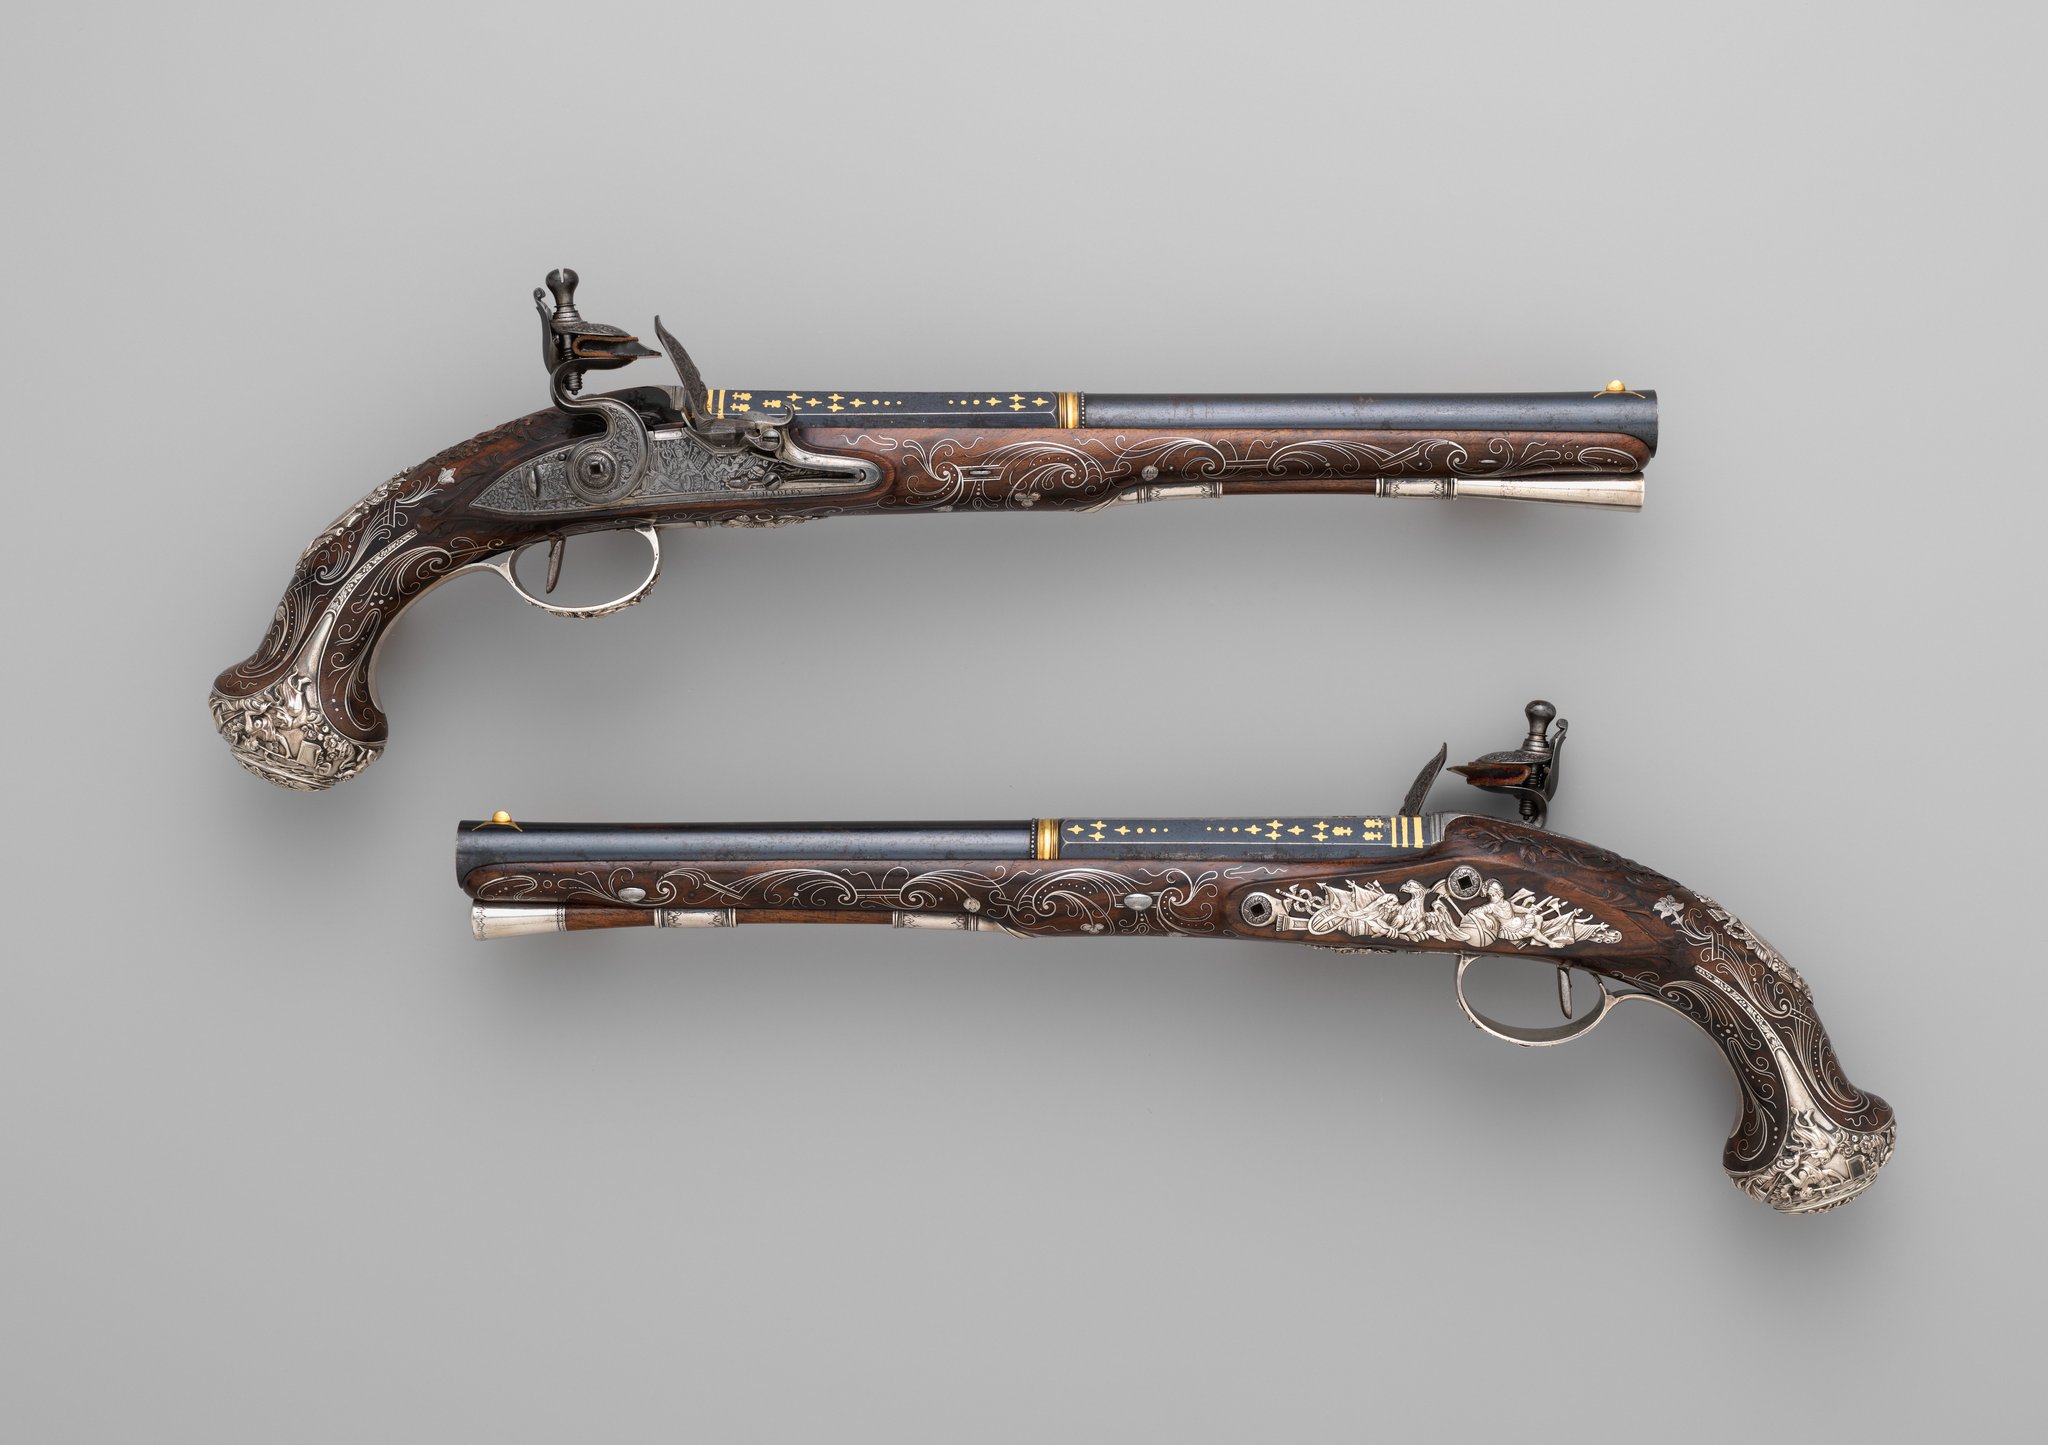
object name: pair of flintlock pistol with square drive key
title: Pair of Flintlock Pistols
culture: british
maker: henry hadley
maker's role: gunsmith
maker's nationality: british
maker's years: -1773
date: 1765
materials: copper alloy, gold, silver, steel, wood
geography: england